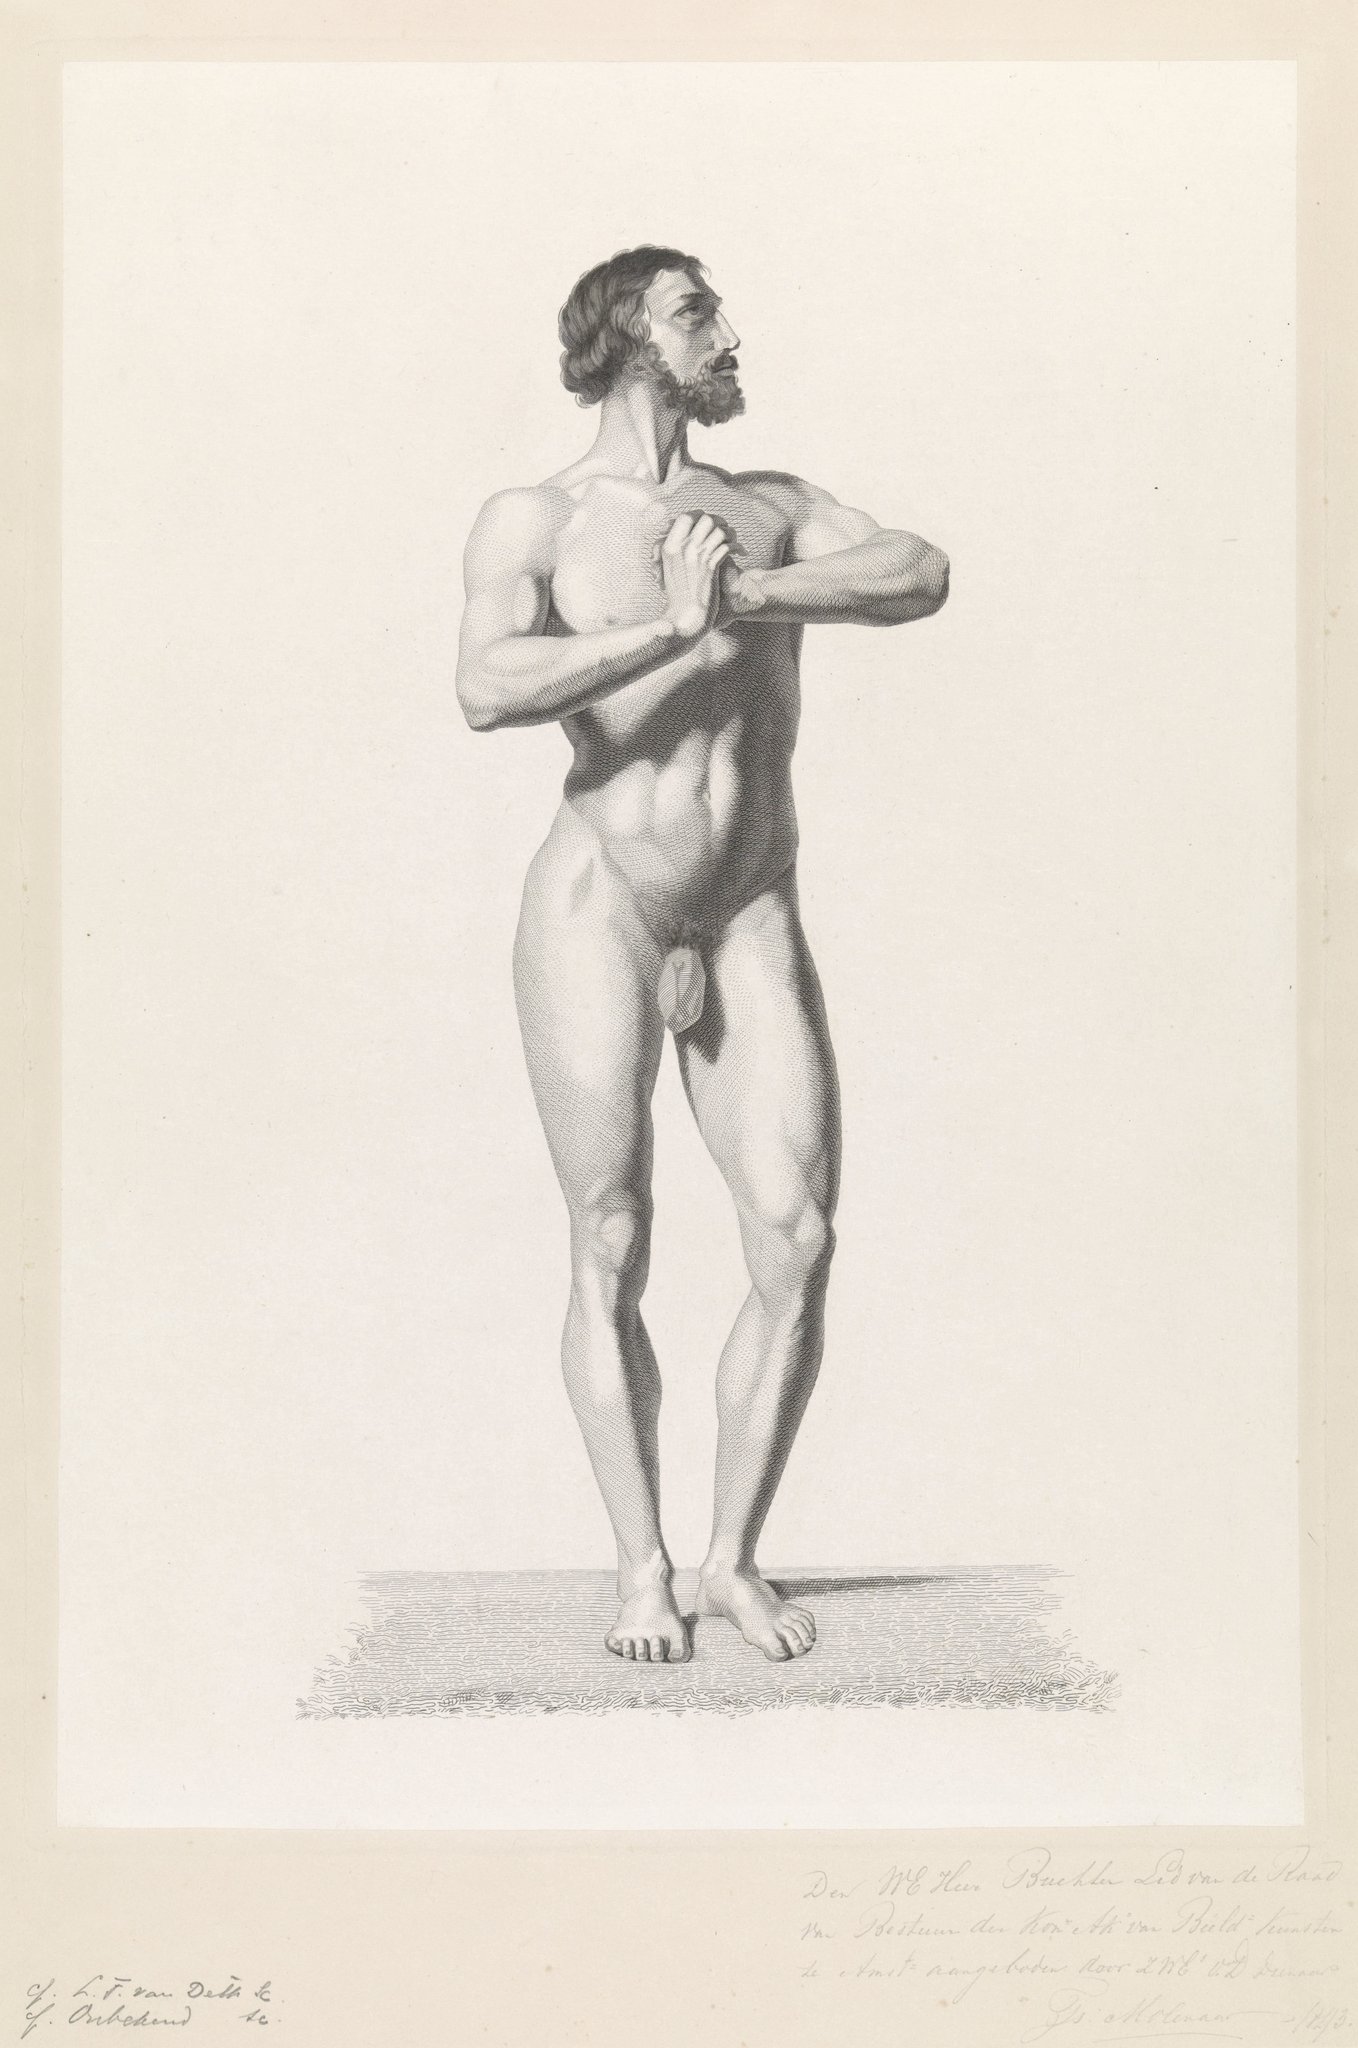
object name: print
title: Staande naakte man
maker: frans molenaar (1821-1886)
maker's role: print maker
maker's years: 1821-1886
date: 1843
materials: paper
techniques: engraving, etching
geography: amsterdam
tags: the (nude) human figure; 'corpo humano' (ripa)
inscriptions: collector's mark: Lugt 2228, inscription: ‘Den WE Heer Buchter Lid van de Raad van Bestuur der Kon" Ak" van Beeld" Kunsten te Amst" aangeboden door ZWE Dienaar F. Molenaar 1843’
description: Staande naakte man met baard, de handen ineen geslagen.